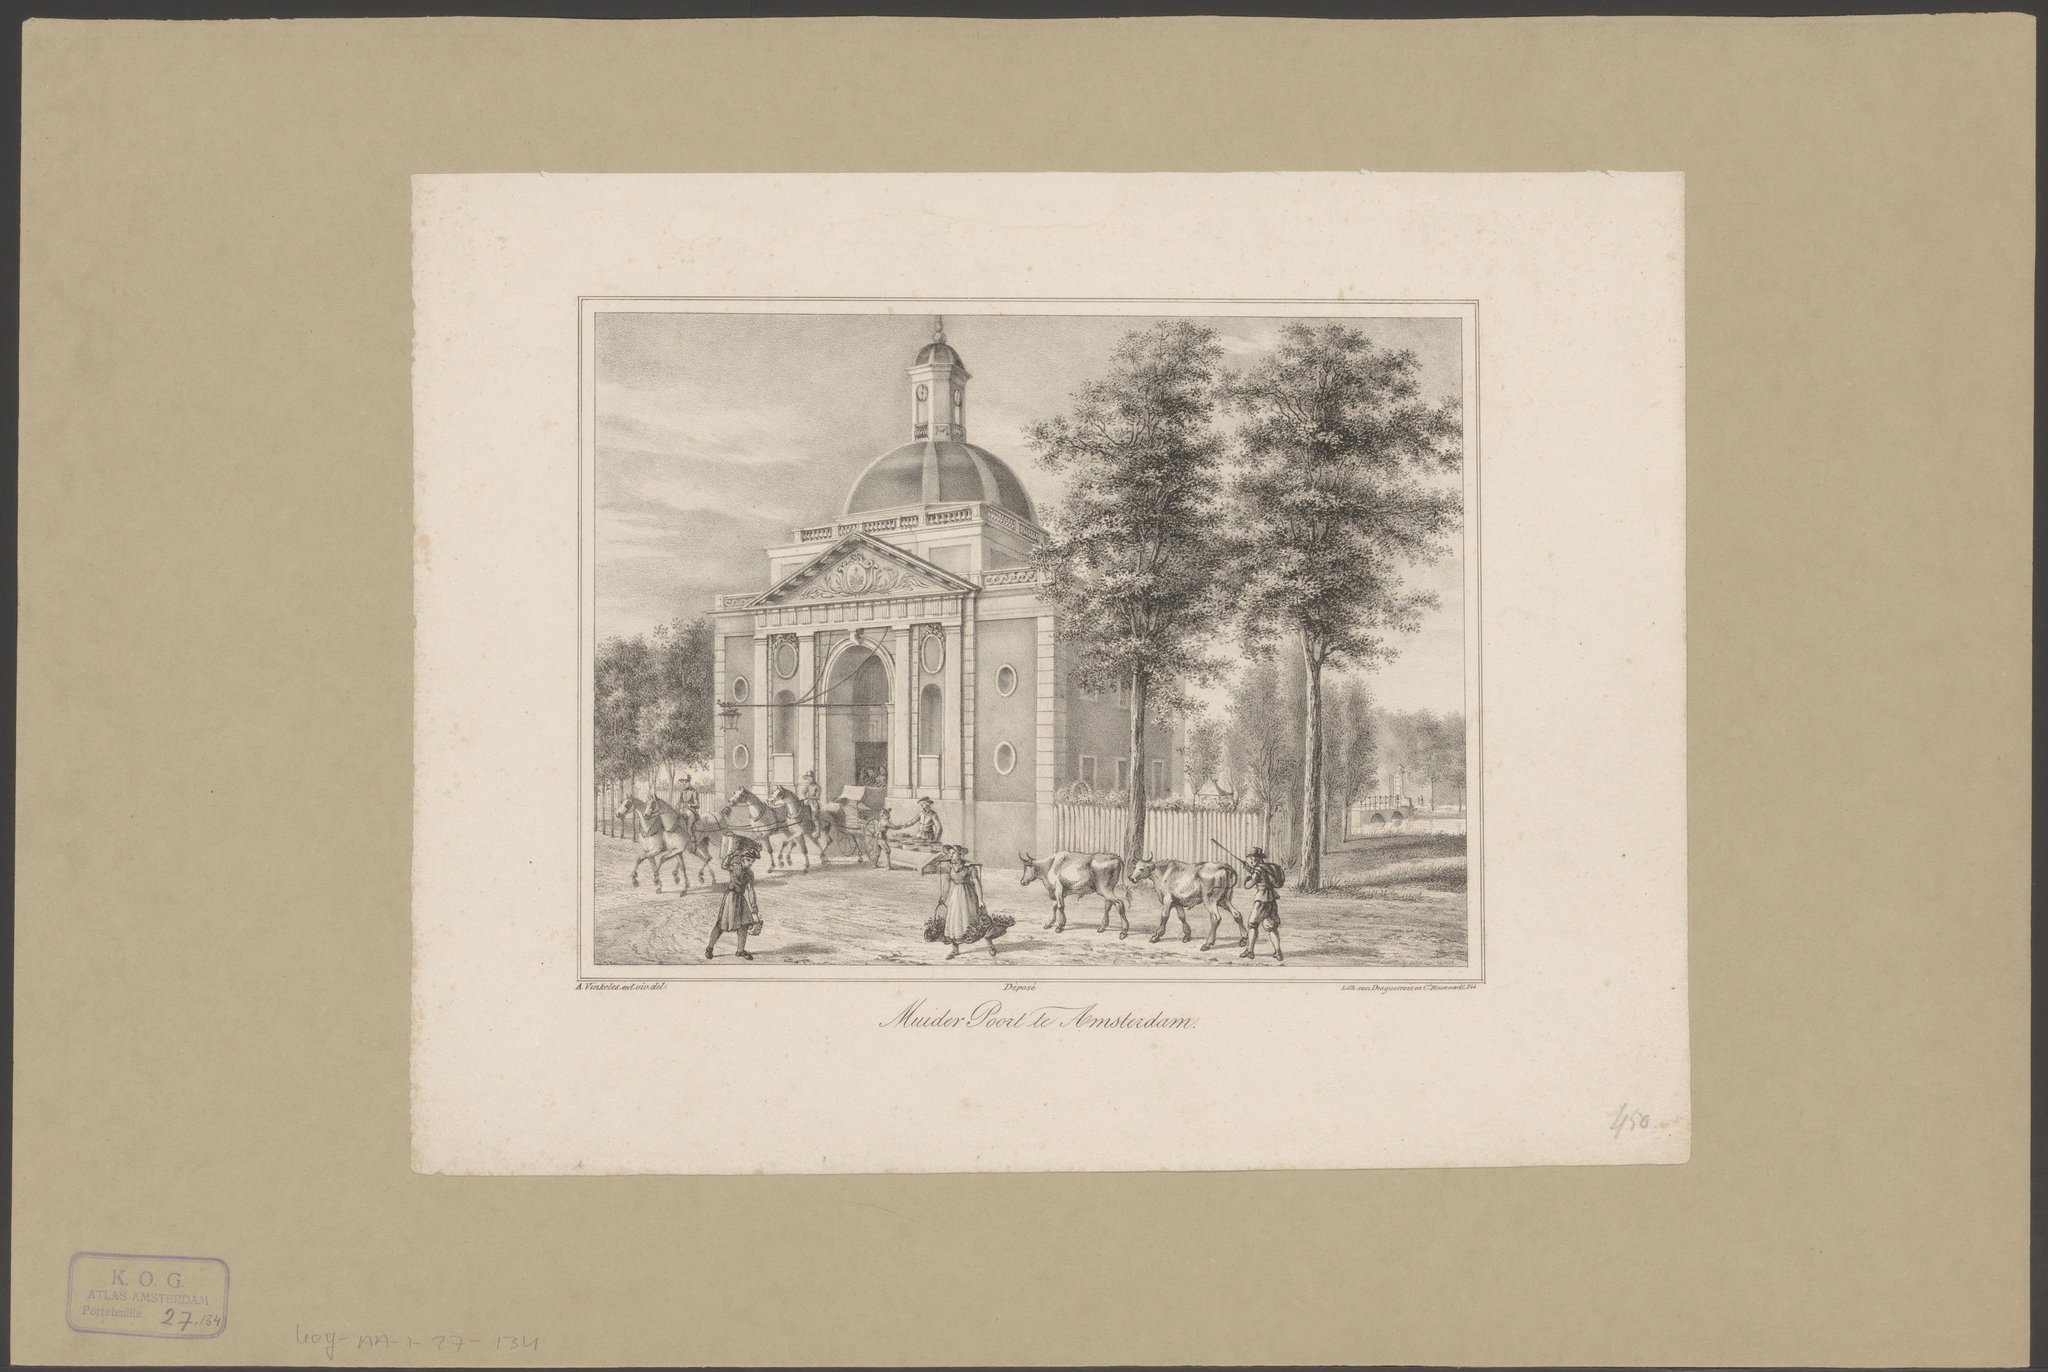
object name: print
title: Gezicht op de Tweede Muiderpoort te Amsterdam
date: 1828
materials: paper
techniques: lithograph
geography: amsterdam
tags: cow, city-gate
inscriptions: : ‘Déposé’, collector's mark: Lugt 1641b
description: Onderdeel van een omslag met een serie van zes lithografieën van Amsterdamse poorten. Onderwerpsrubriek binnen de Atlas Amsterdam: Poorten, verzamelbladen, J. Tweede Muiderpoort.